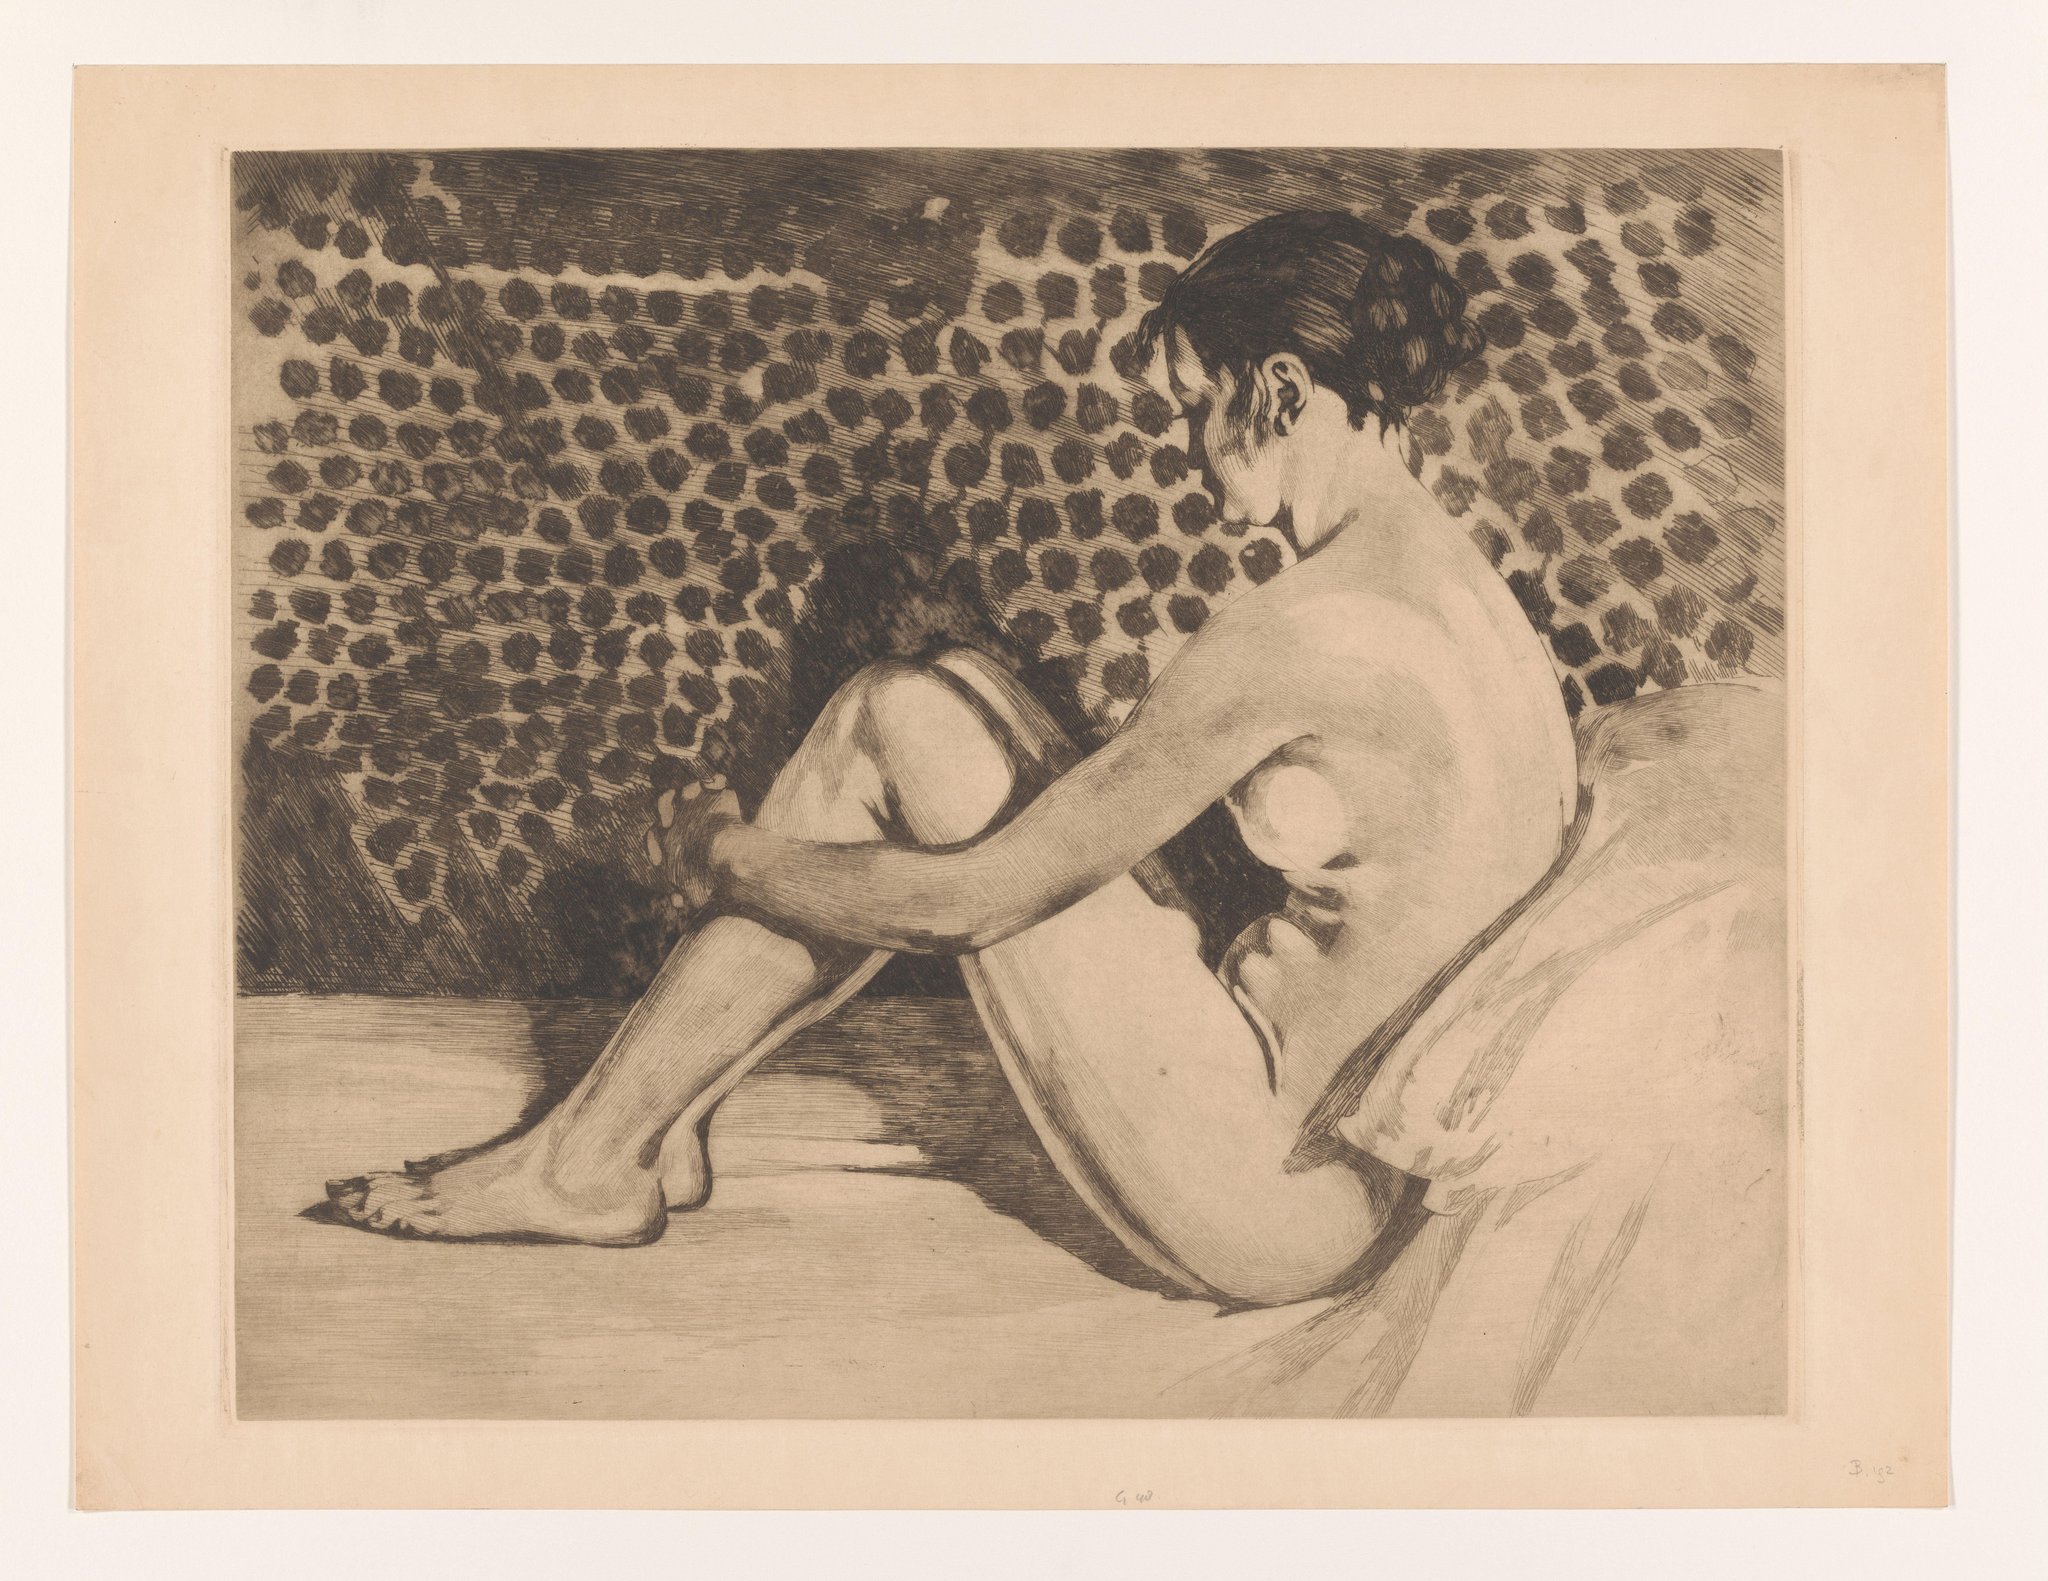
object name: print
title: Naakte jonge vrouw met haar armen om haar knieën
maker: willem witsen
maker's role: draughtsman, painter, print maker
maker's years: 1860-1923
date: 1922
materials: paper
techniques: etching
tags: the ages of man, woman (showing herself) undressed, quasi-nude